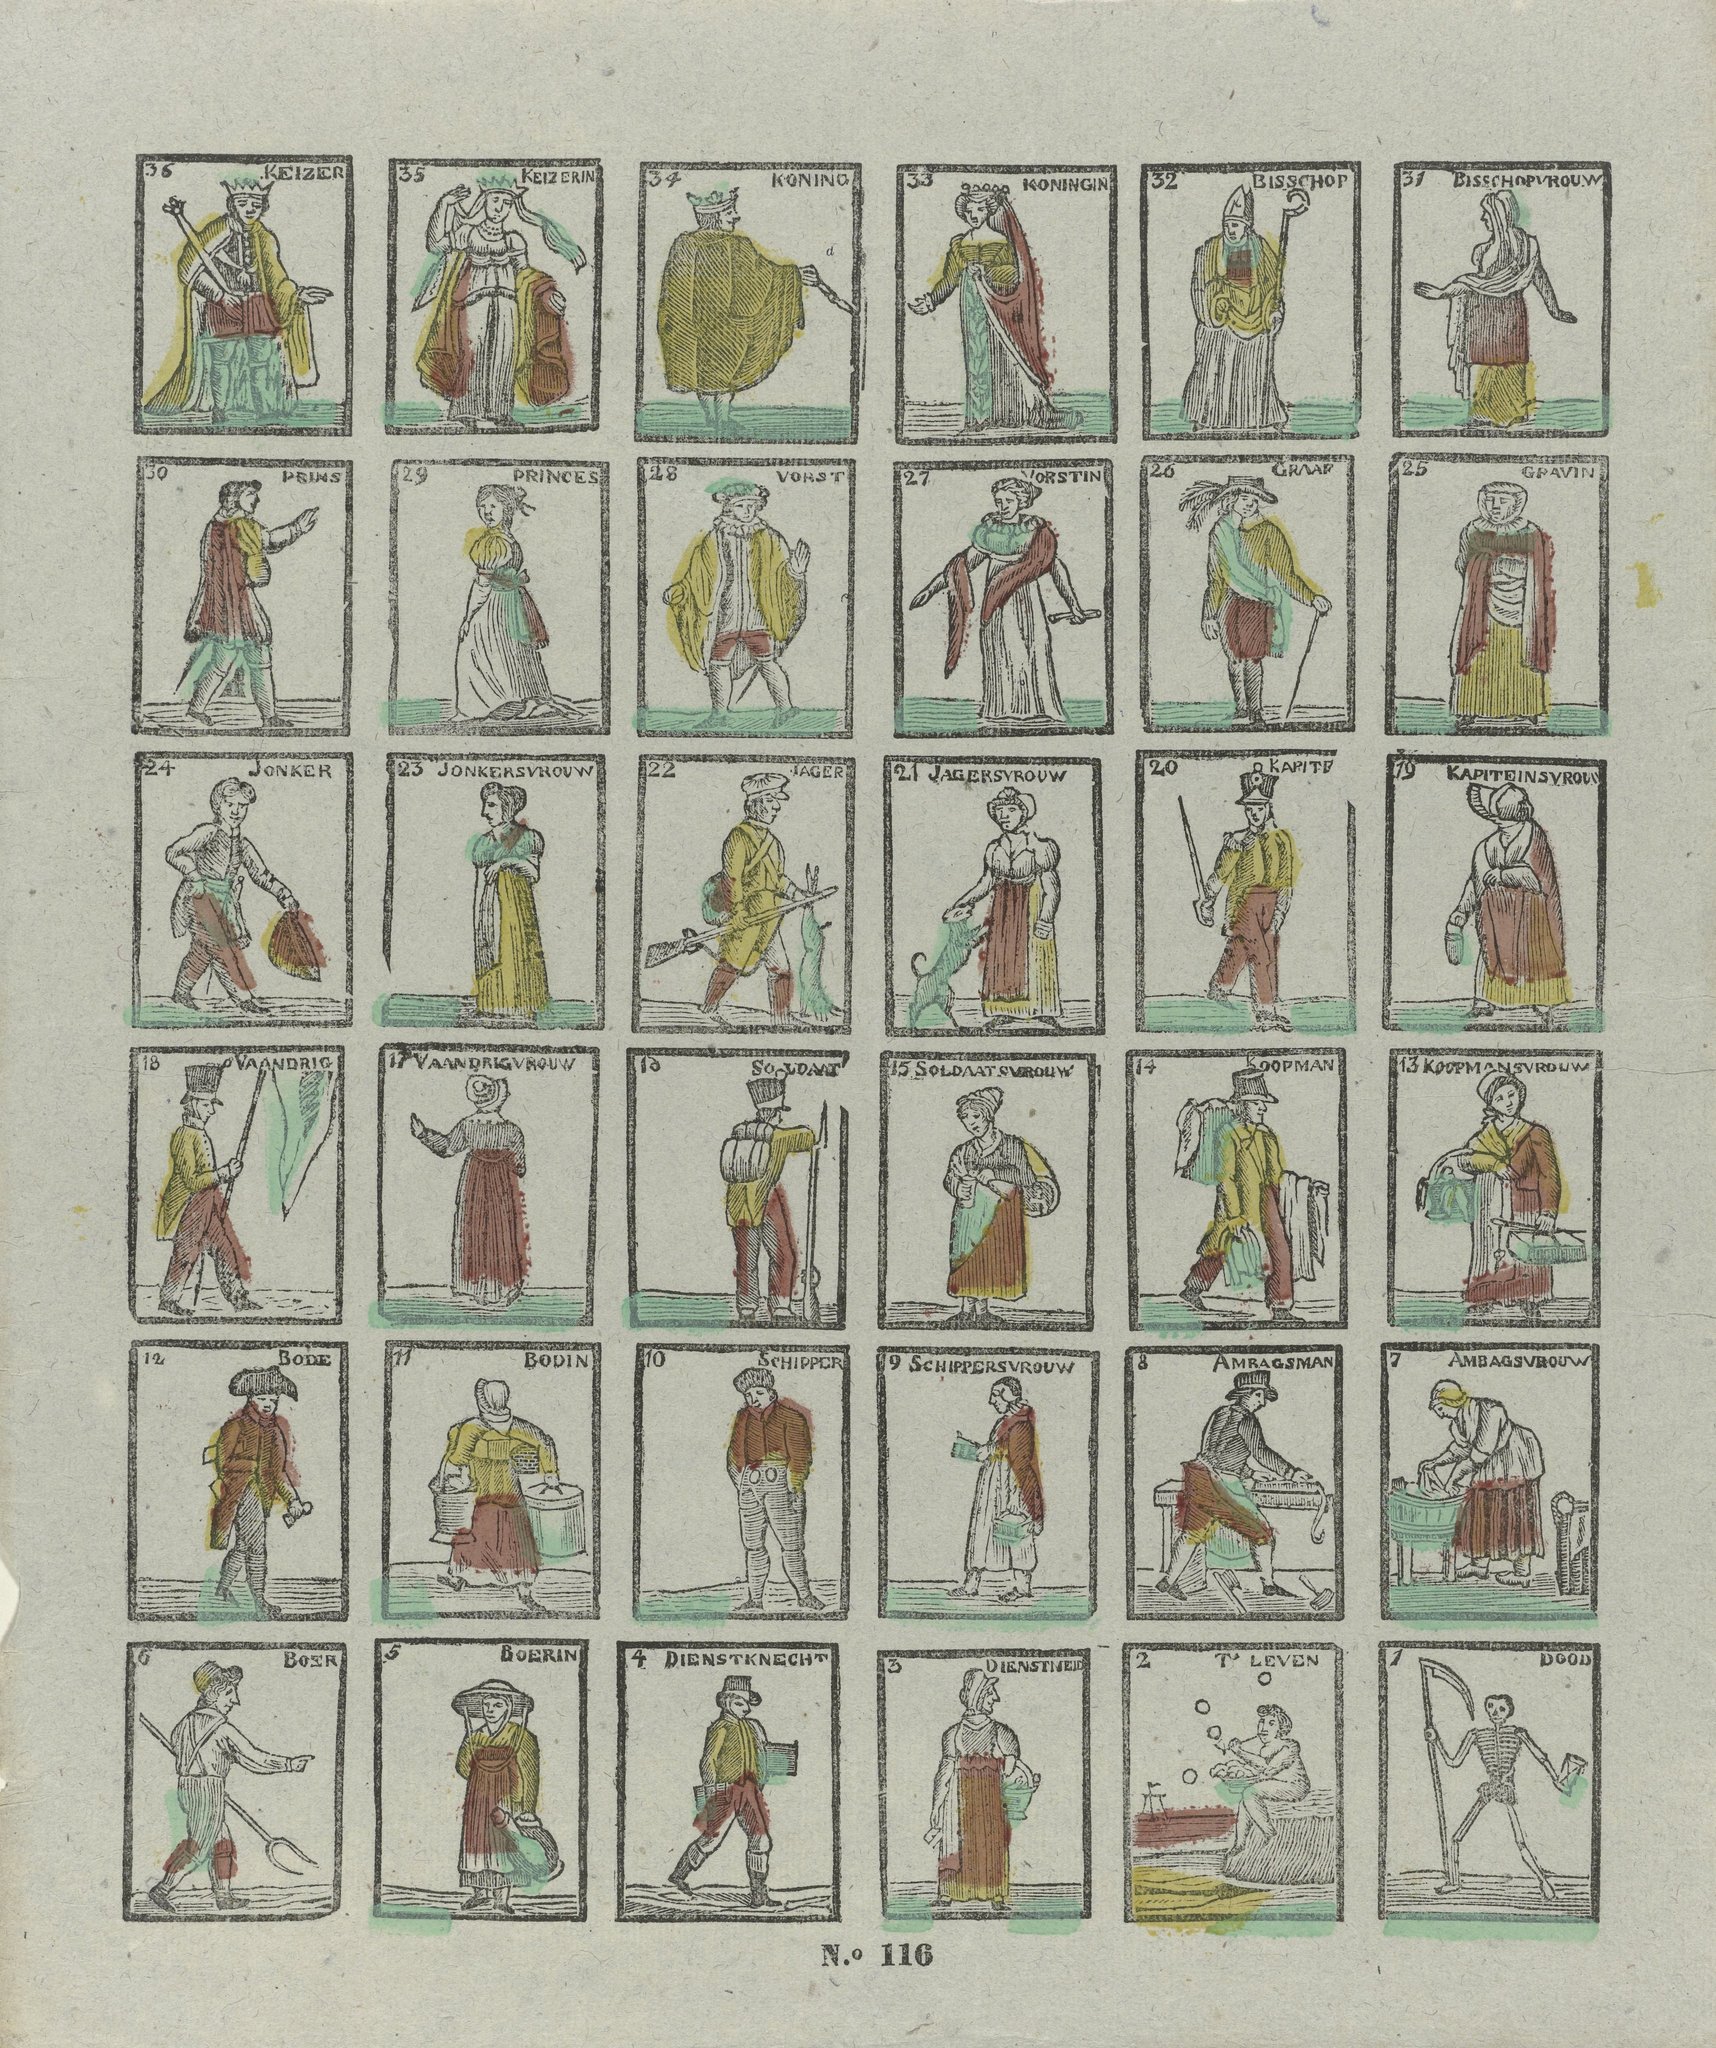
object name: card game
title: Floskaartjes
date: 1800-1833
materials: paper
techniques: colour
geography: turnhout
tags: symbols and personifications of death, social position, playing-cards, nobility and patriciate; chivalry, knighthood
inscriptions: collector's mark: Lugt 2760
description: Blad met 36 speelkaarten (floskaartjes) met voorstellingen van verschillende figuren. De afbeeldingen vormen achttien paren, oplopend genummerd van bovenaan links nummer 1 tot onderaan rechts nummer 36. Op de twee laagste nummers na tonen ze zeventien koppels, man en vrouw, met de man net één nummer hoger dan de vrouw, waarbij elk paar een beroep of een maatschappelijke positie voorstelt. Genummerd midden onder: No. 116.